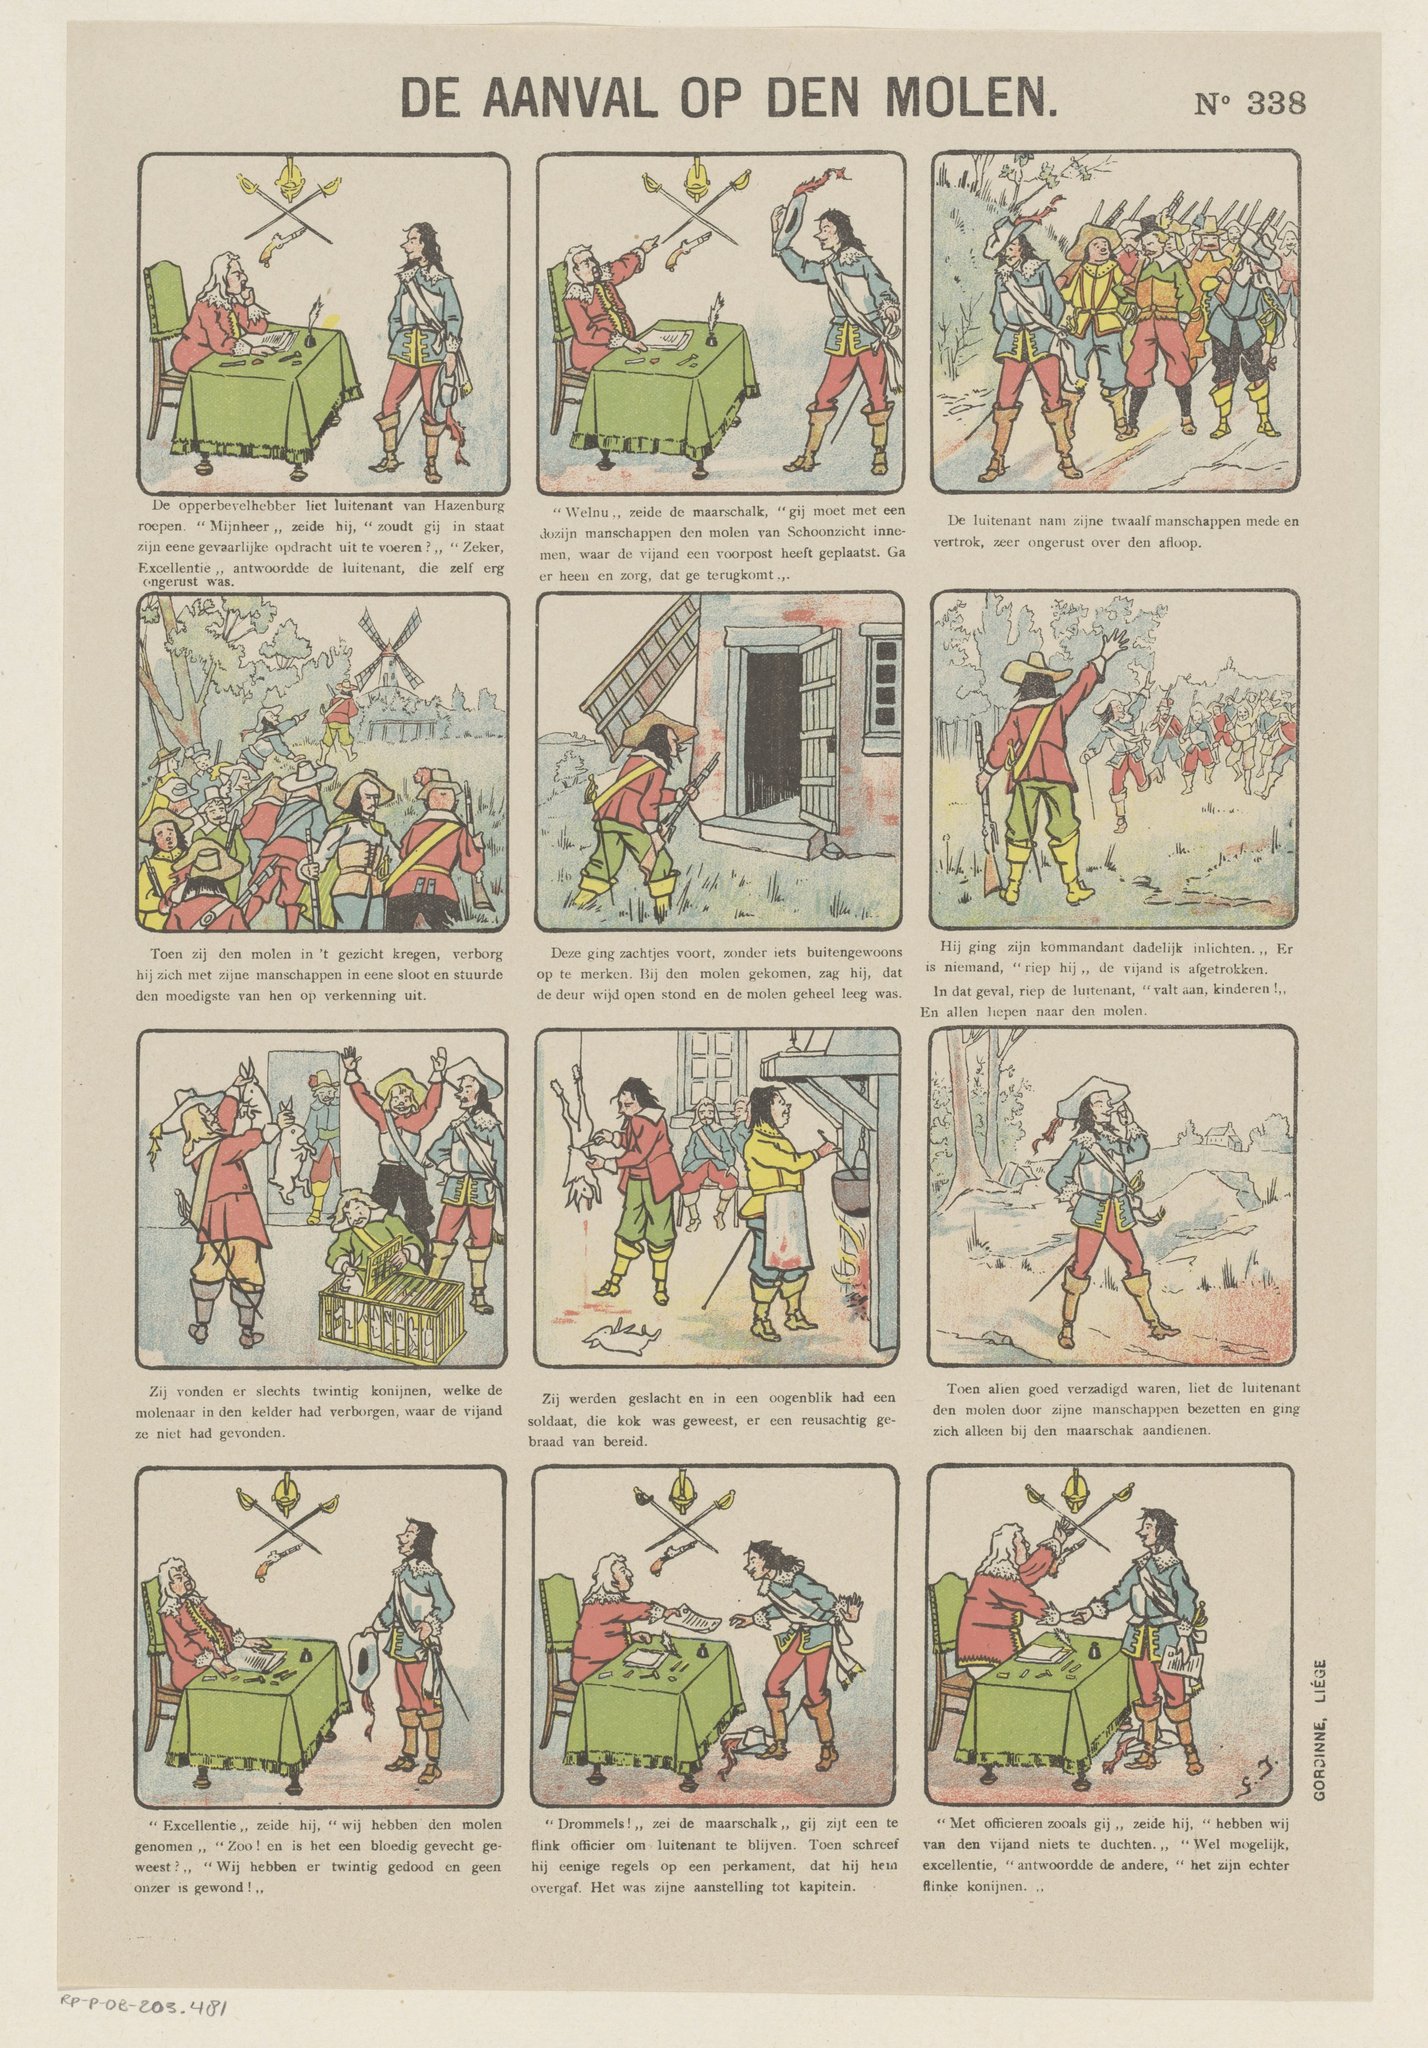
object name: print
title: De aanval op den molen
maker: monogrammist g.j.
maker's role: print maker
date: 1894-1959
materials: paper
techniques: lithograph, letterpress printing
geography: liège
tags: ranks in the army, the soldier; the soldier's life, windmill, rodents: rabbit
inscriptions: collector's mark: Lugt 2760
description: Blad met 12 voorstellingen over Hannibal van Hazenburg die met zijn manschappen een verlaten molen inneemt. In de molen vinden de mannen twintig konijnen en eten deze op. Voor zijn zogenaamde heldendaden (de dood van twintig) ontvangt Van Hazenburg de graad van kapitein. Onder elke afbeelding een onderschrift. Genummerd rechtsboven: No 338.